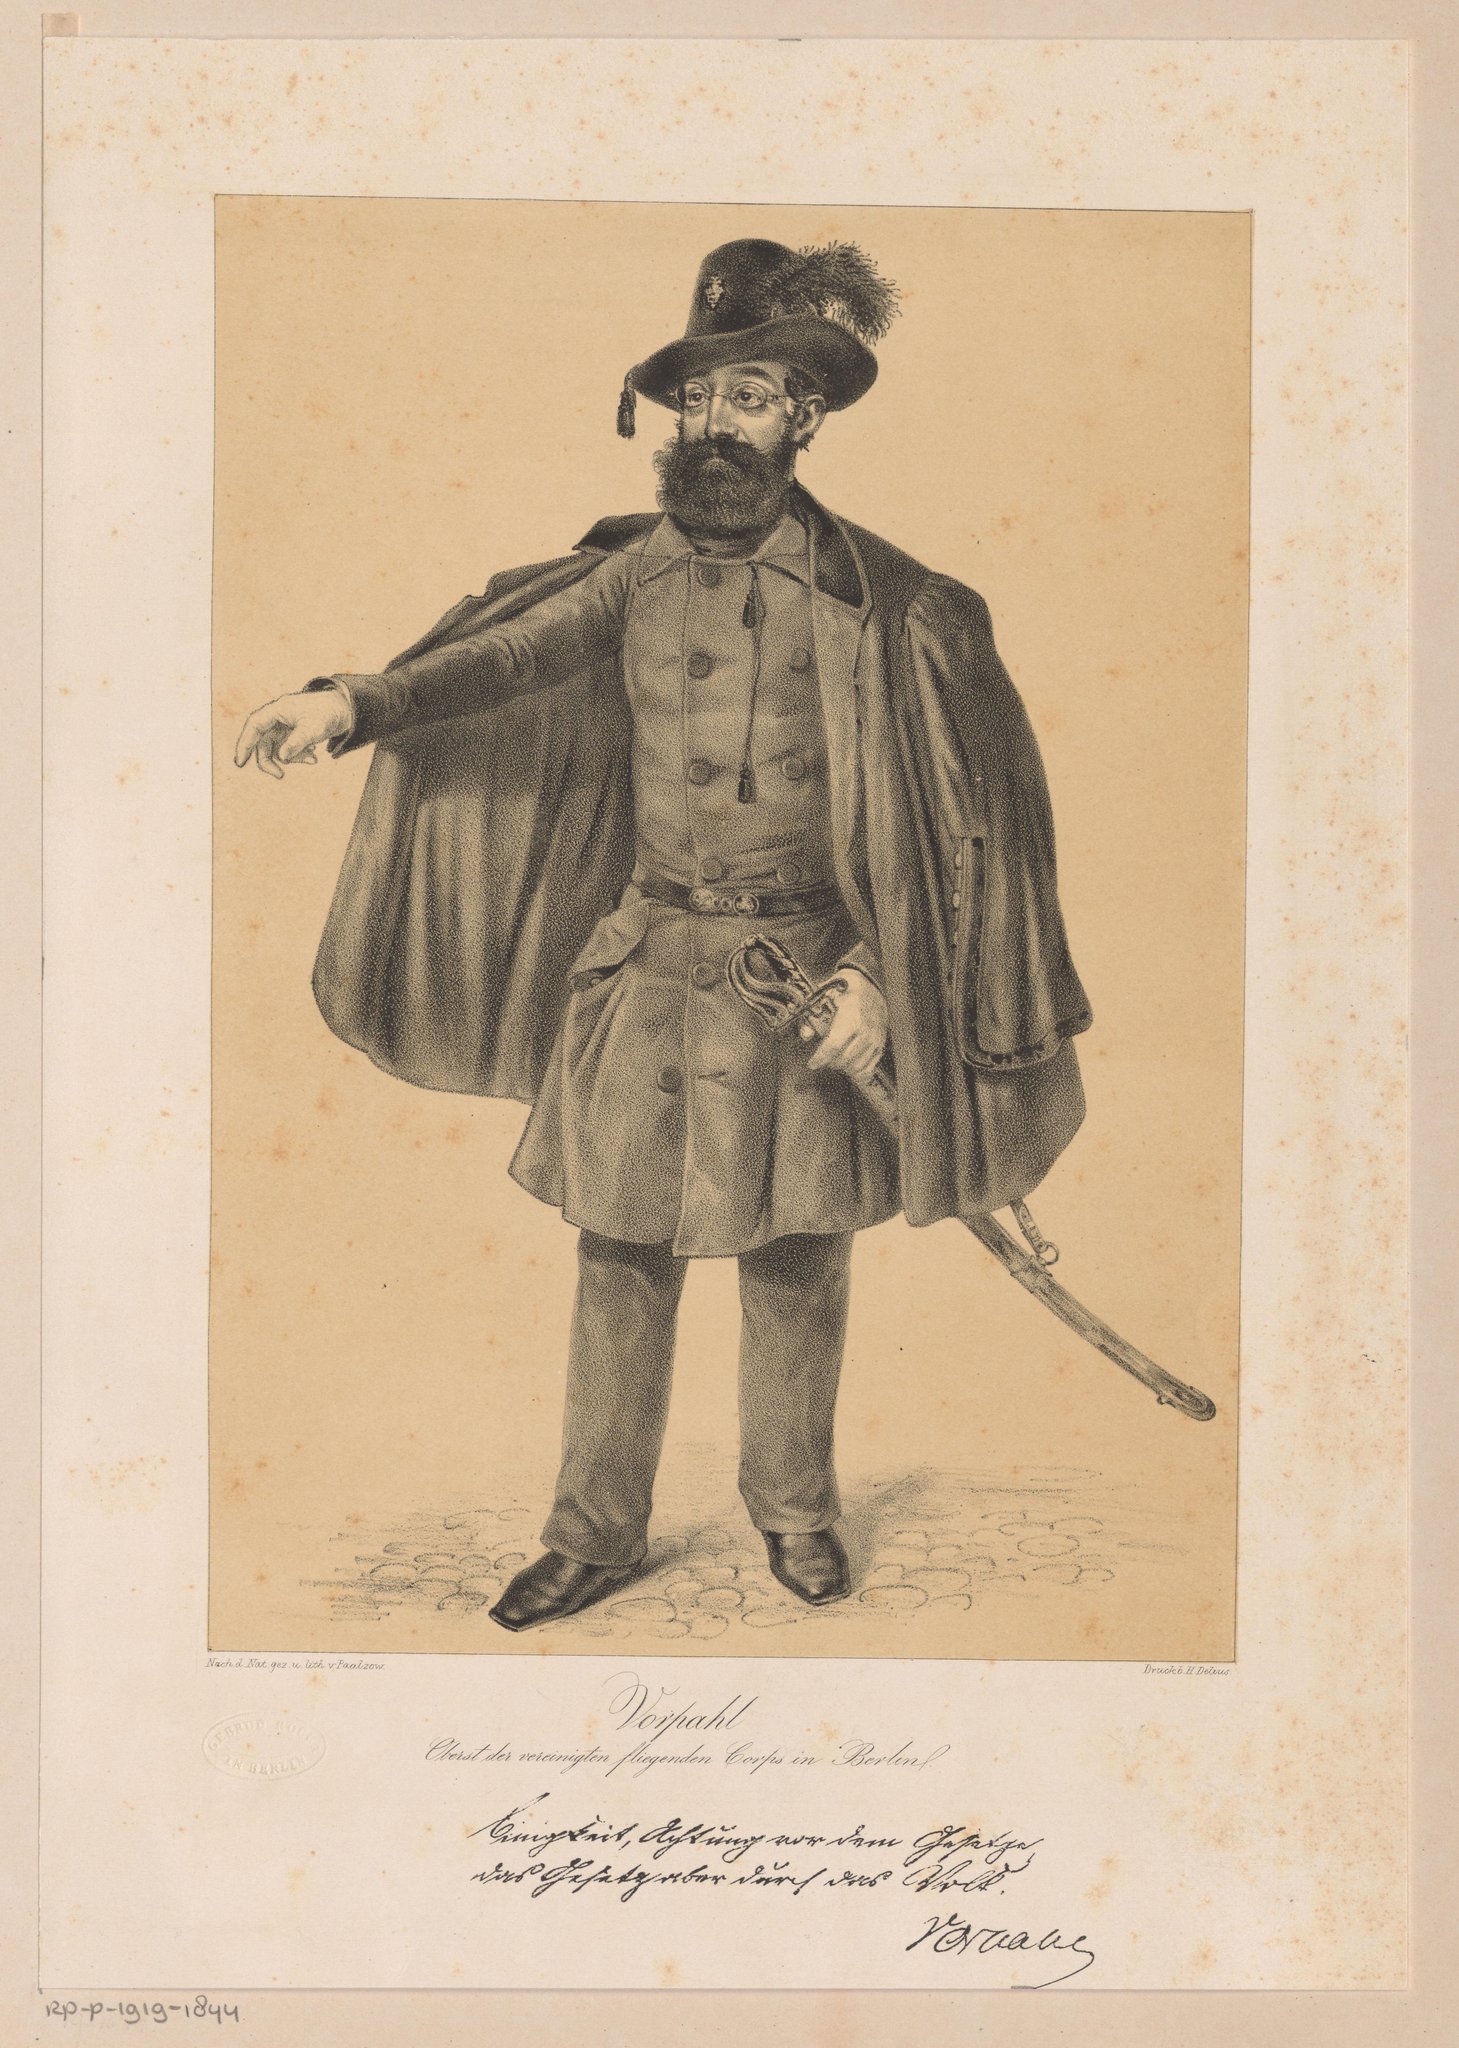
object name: print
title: Portret van een onbekende man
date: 1842-1860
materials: paper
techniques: tone lithography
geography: berlin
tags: anonymous historical person portrayed alone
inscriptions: check stamp: ‘Gebrud Rocca / In Berlin’, collector's mark: Lugt 2228